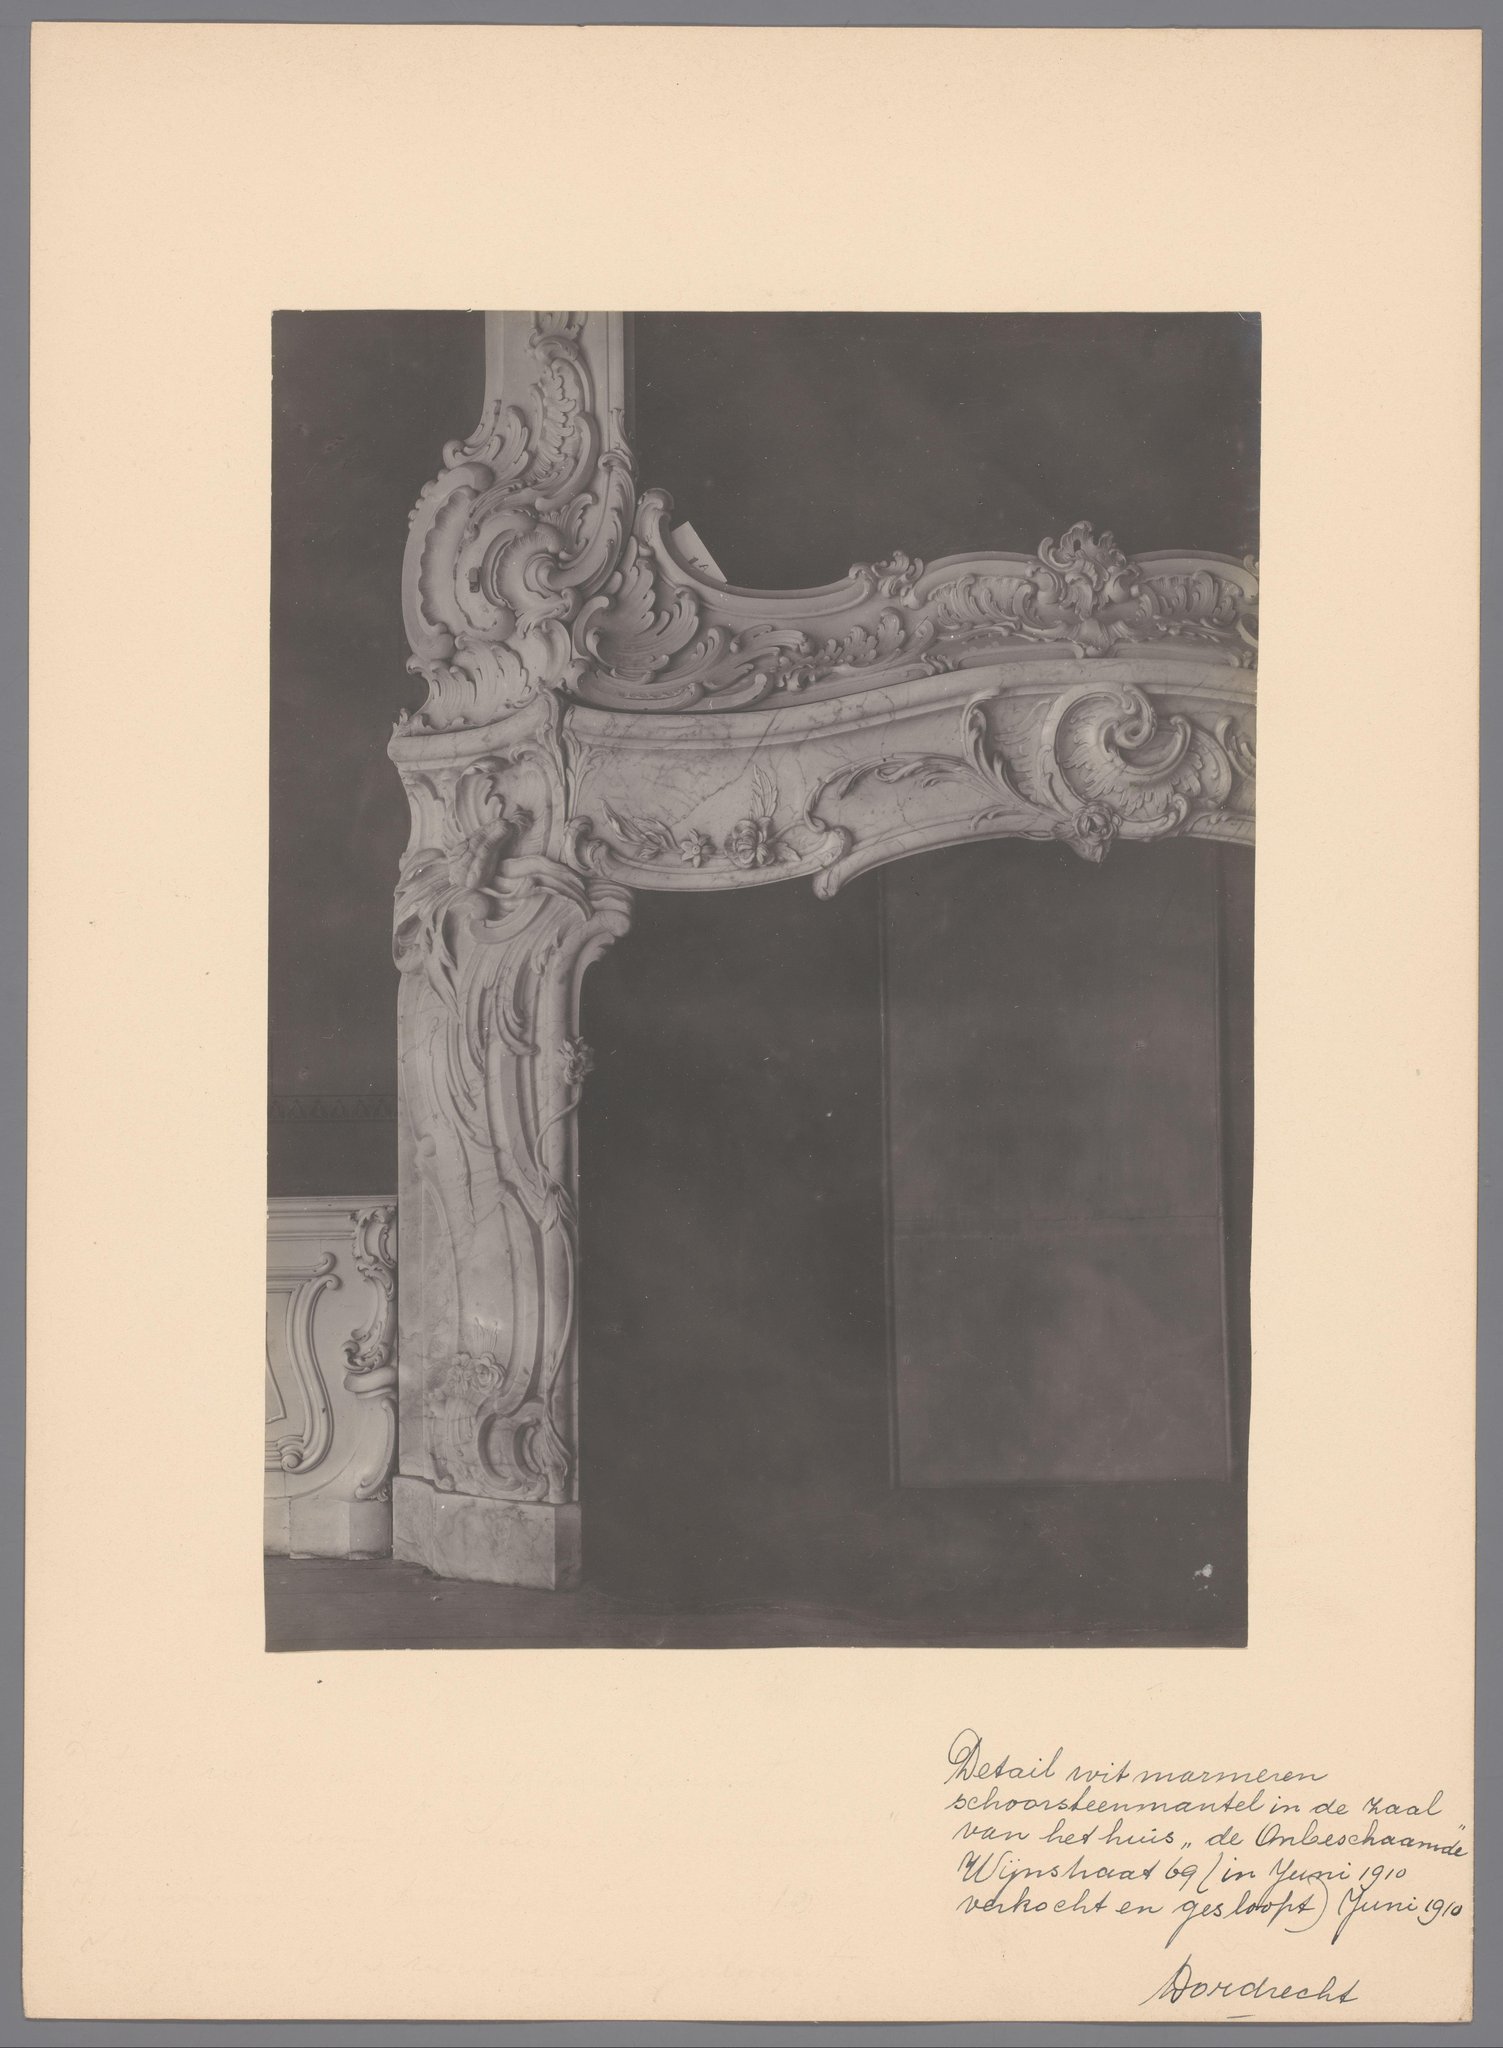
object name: photograph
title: Detail van een Marmeren schoorsteenmantel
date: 1910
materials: cardboard, photographic support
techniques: gelatin silver print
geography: wijnstraat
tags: open hearth, fire-place, interior of the house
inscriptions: annotation: ‘Detail wit marmeren schoorsteenmantel in de Zaal van het huis "de Onbeschaamde". Wijnstraat 69 (in Juni 1910 verkocht en gesloopt)/ Juni 1910/ Dordrecht’